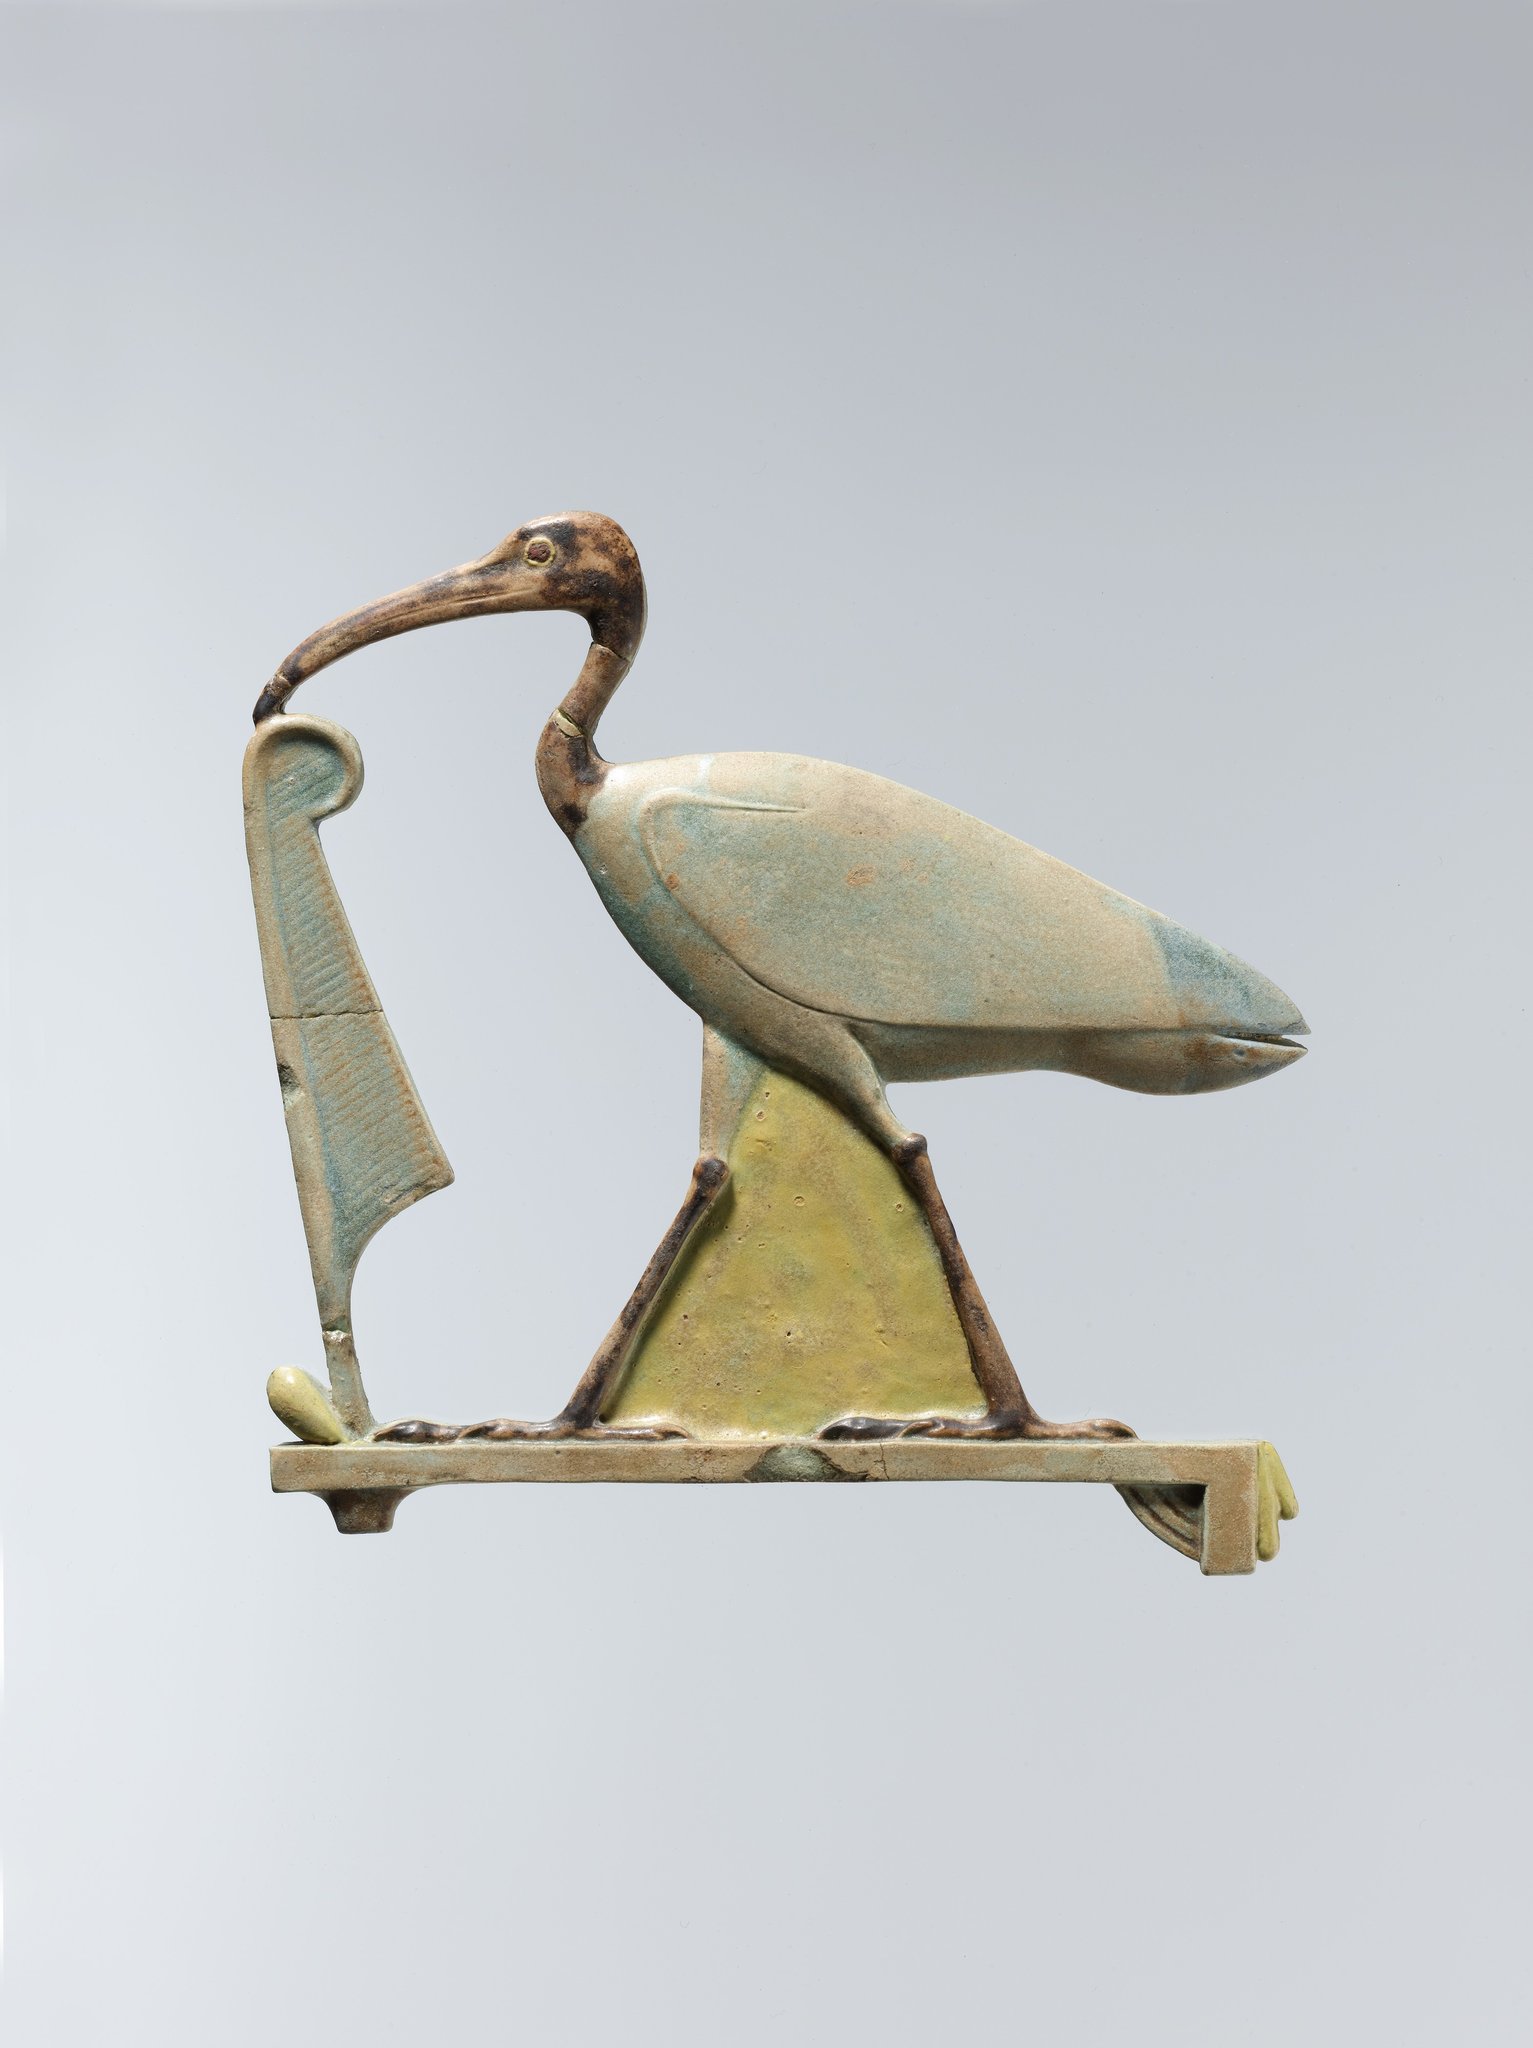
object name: inlay, ibis, maat feather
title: Inlay depicting Thoth as the ibis with a Maat feather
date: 360-343 BCE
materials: faience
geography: middle egypt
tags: birds